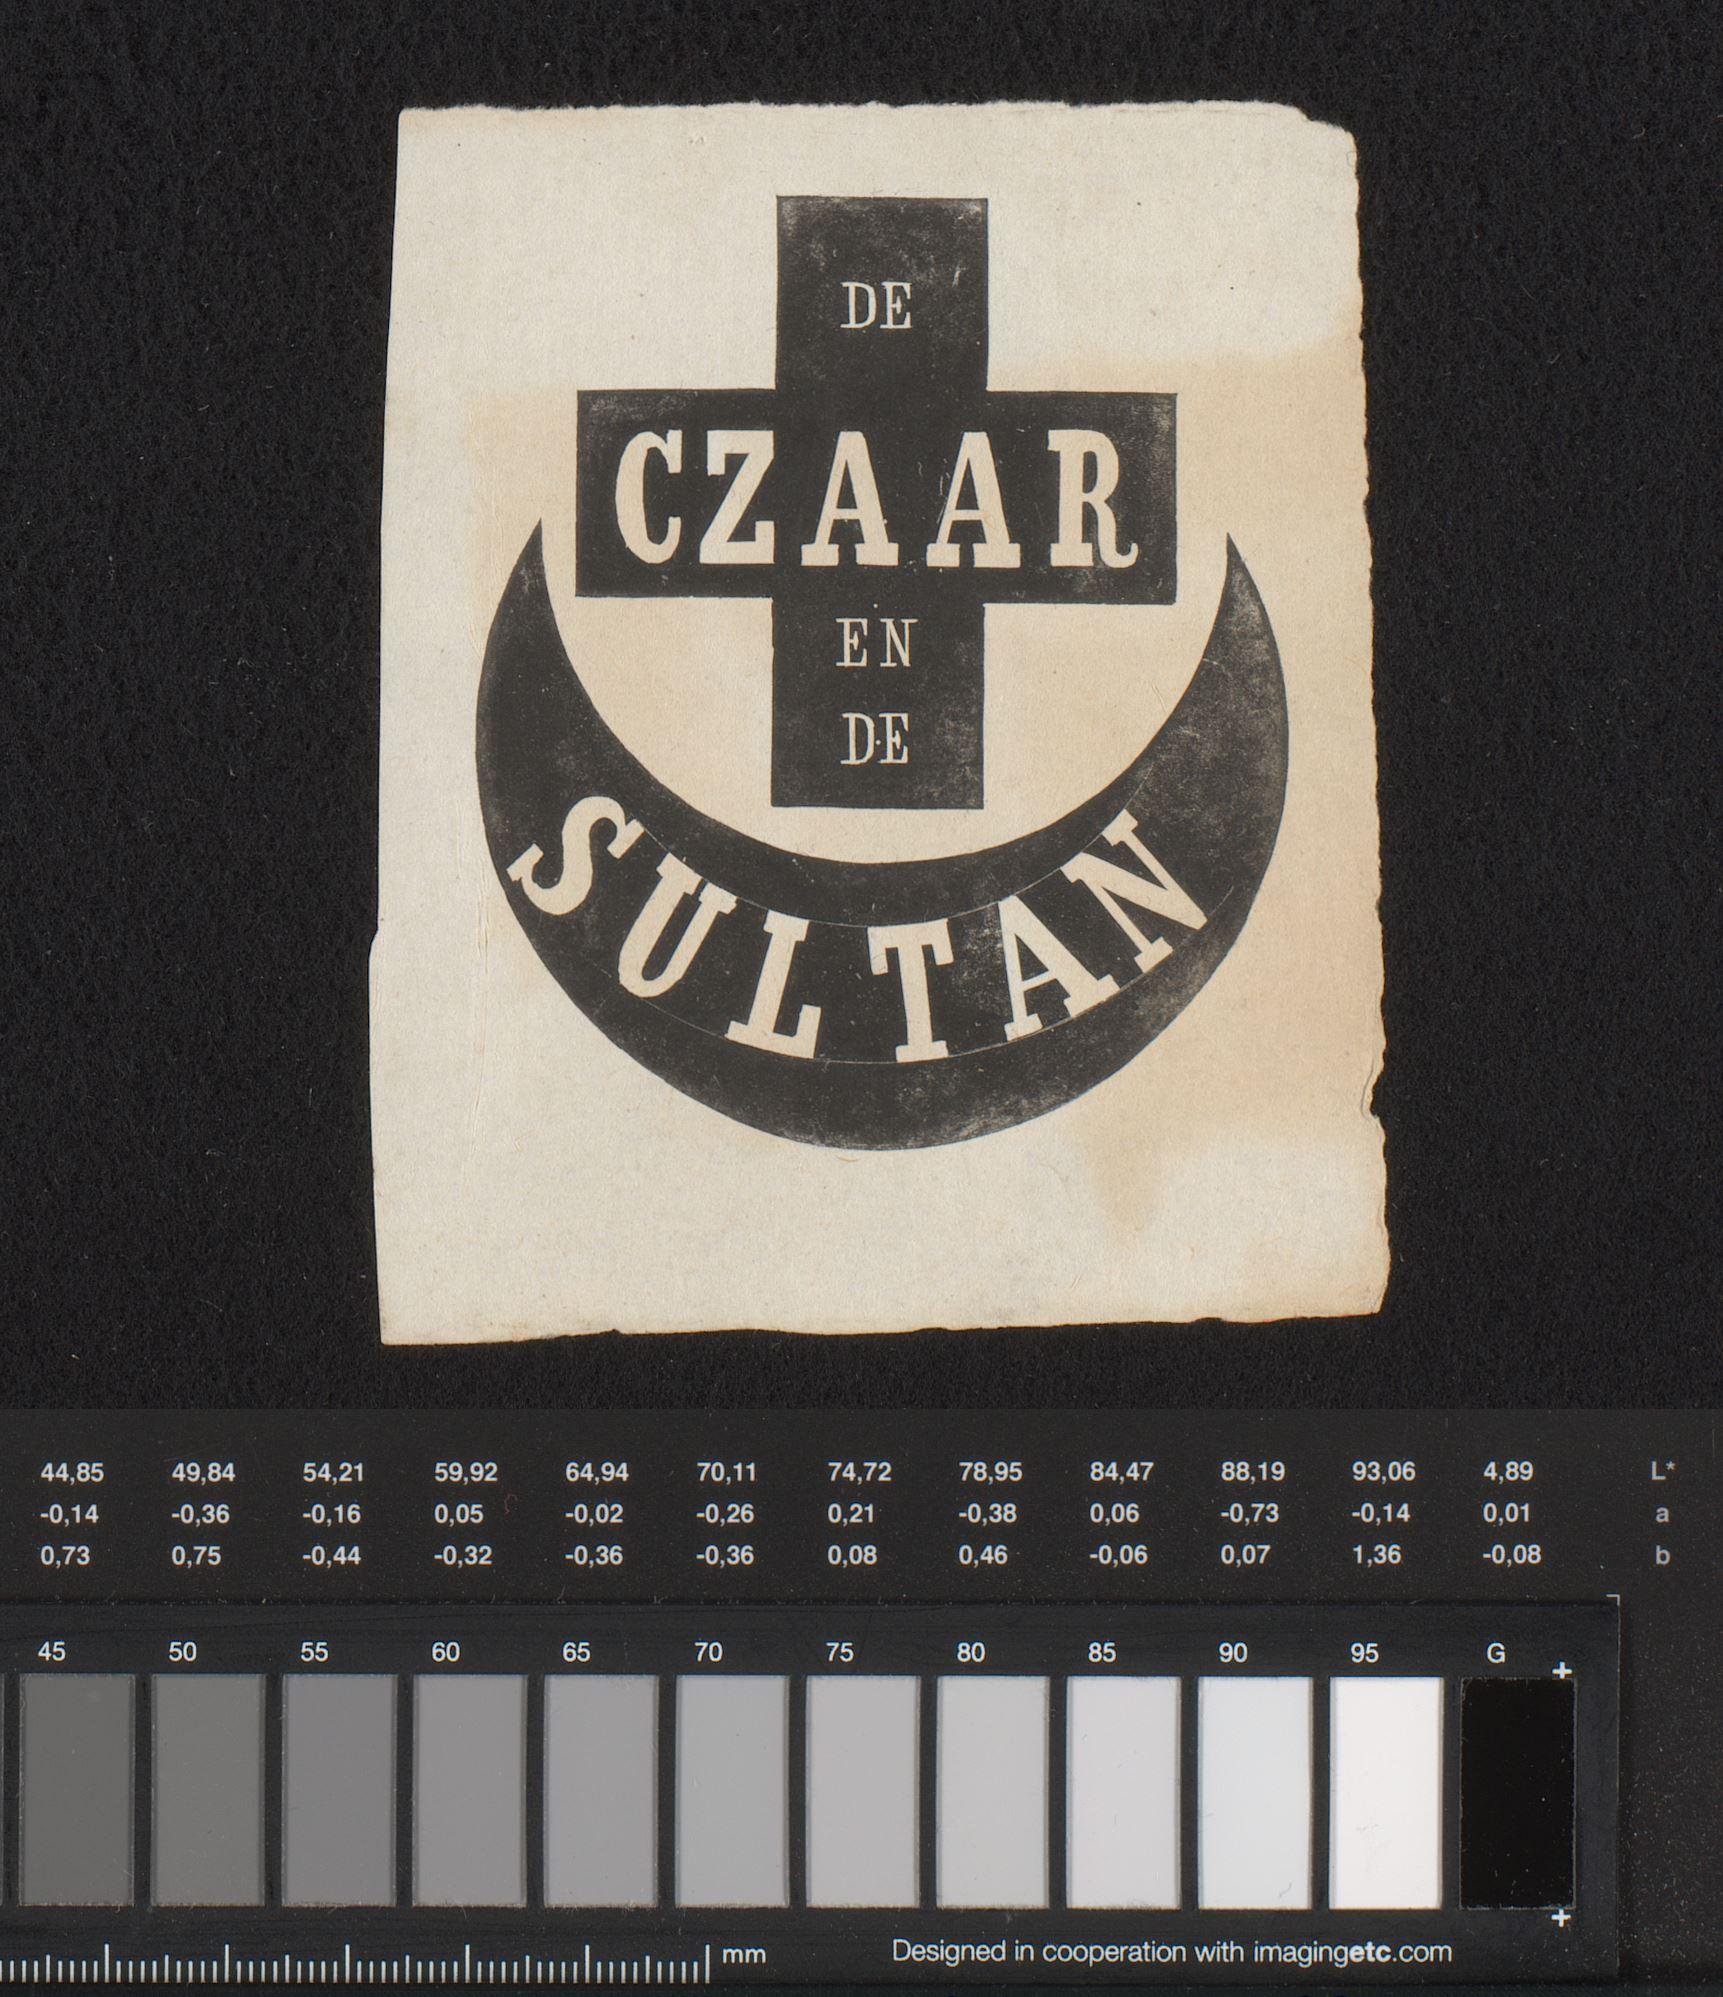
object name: print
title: Kruis en halve maan met daarin de woorden 'De czaar en de sultan'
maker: isaac weissenbruch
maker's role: print maker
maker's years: 1826-1912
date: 1836-1912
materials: paper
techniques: engraving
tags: moon as celestial body, specific forms of the cross